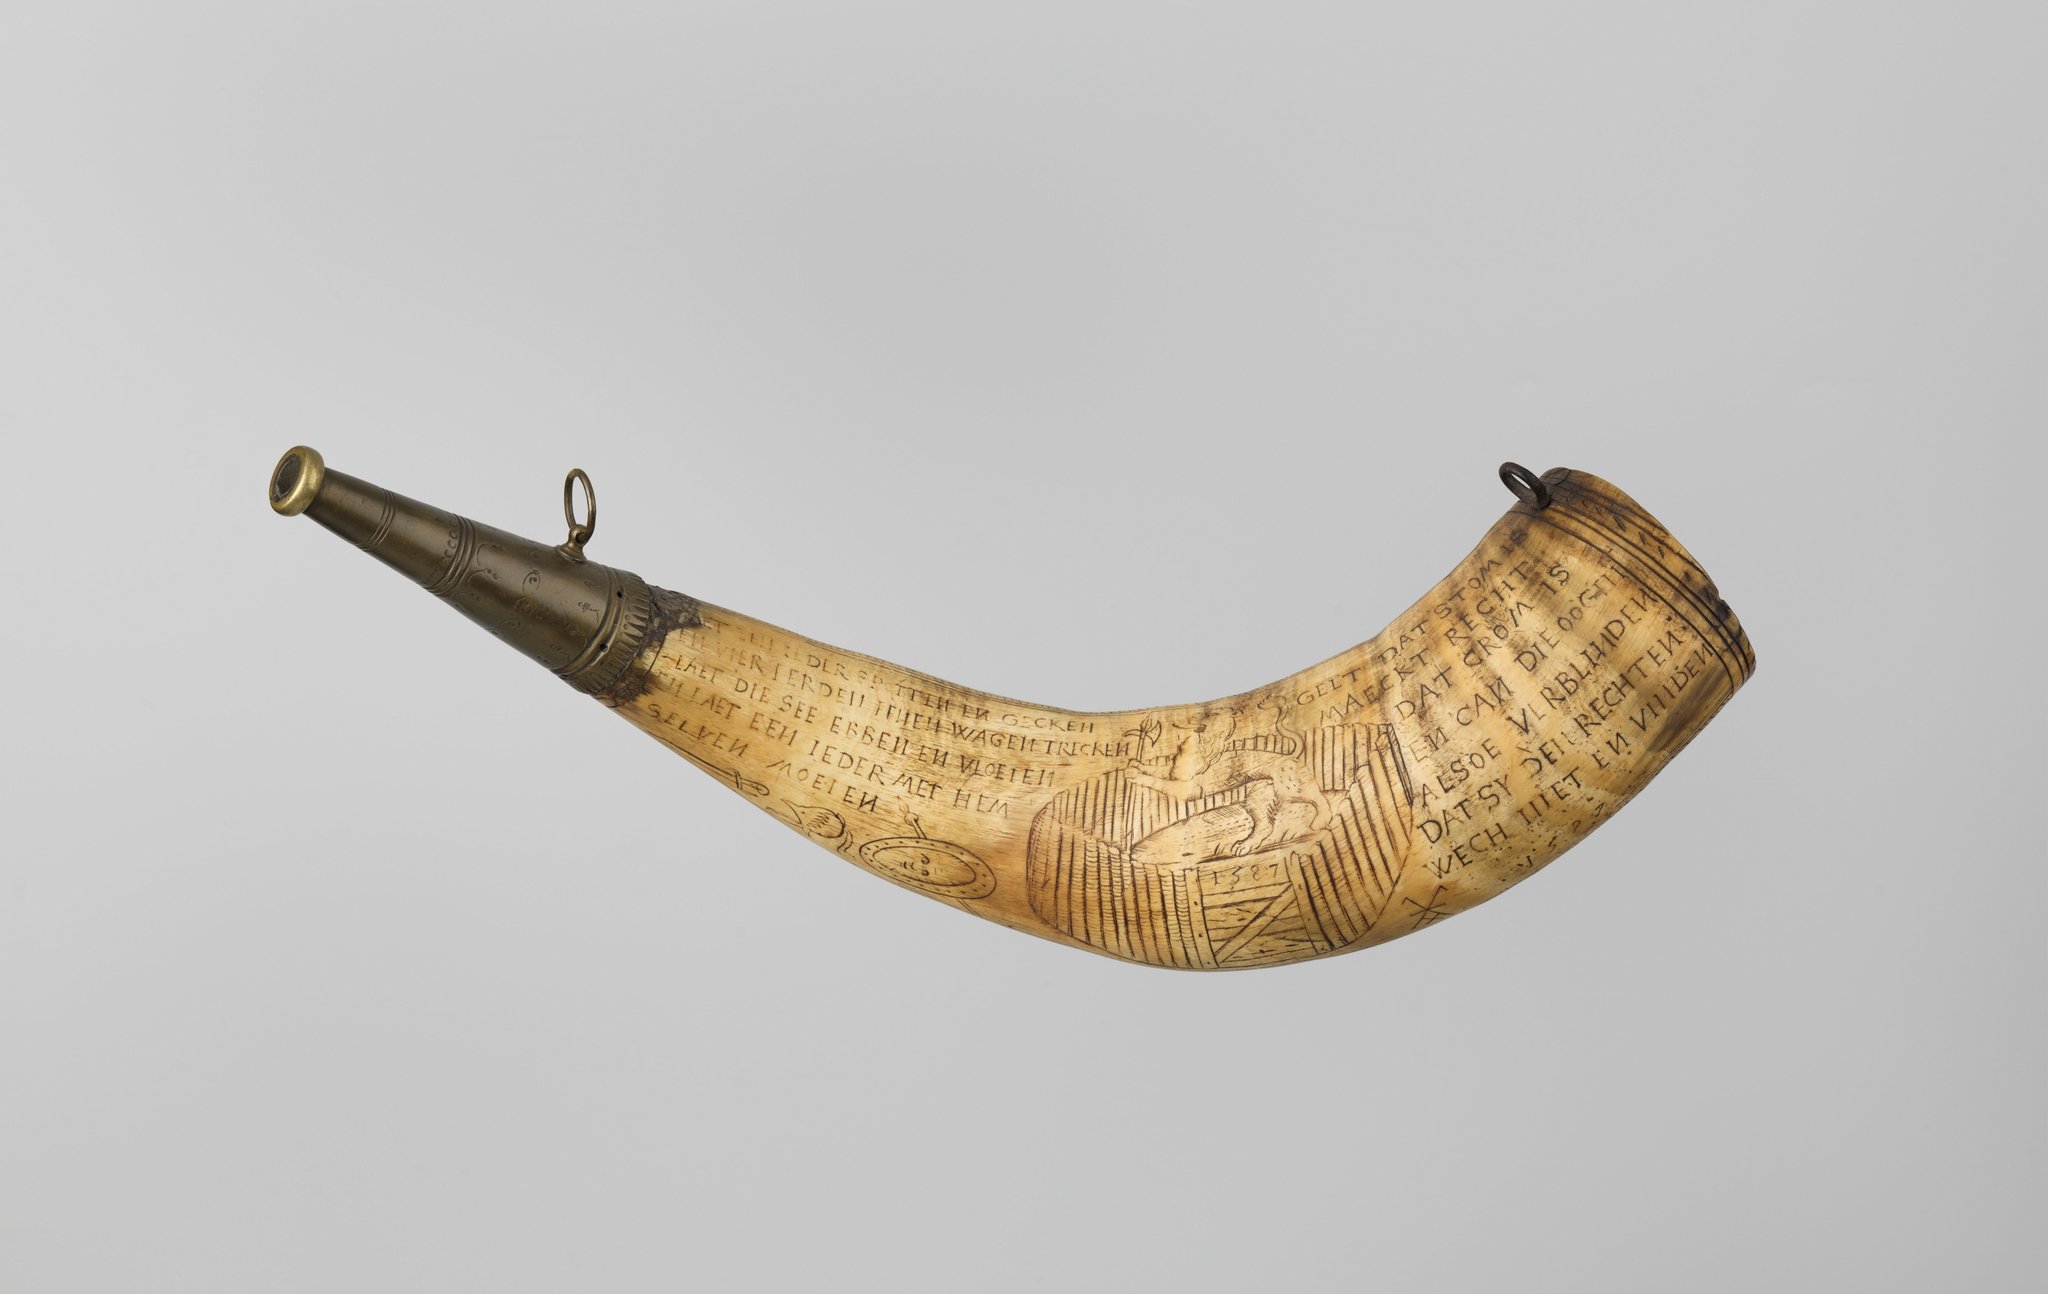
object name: musical instrument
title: Horn (end-blown horn)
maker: Anonymous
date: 1587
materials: copper, horn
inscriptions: inscription: ‘Laet een ieder spotten en gecken En vier perden ienen wagen trecken Laet die see ebben en vloeien En laet een ieder met hem selven moeien Gelt dat stom is Maekt recht dat crom is En can die oghen alsoe verblinden Dat sy den rechten wech niet en vinden’, date: ‘1587’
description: Jachthoorn, waarop gesneden in het midden de Hollandse tuin met de leeuw en inscriptie: LAET EEN IEDER SPOTTEN EN GEKKEN...Verder een jacht op een wild zwijn, 1587.